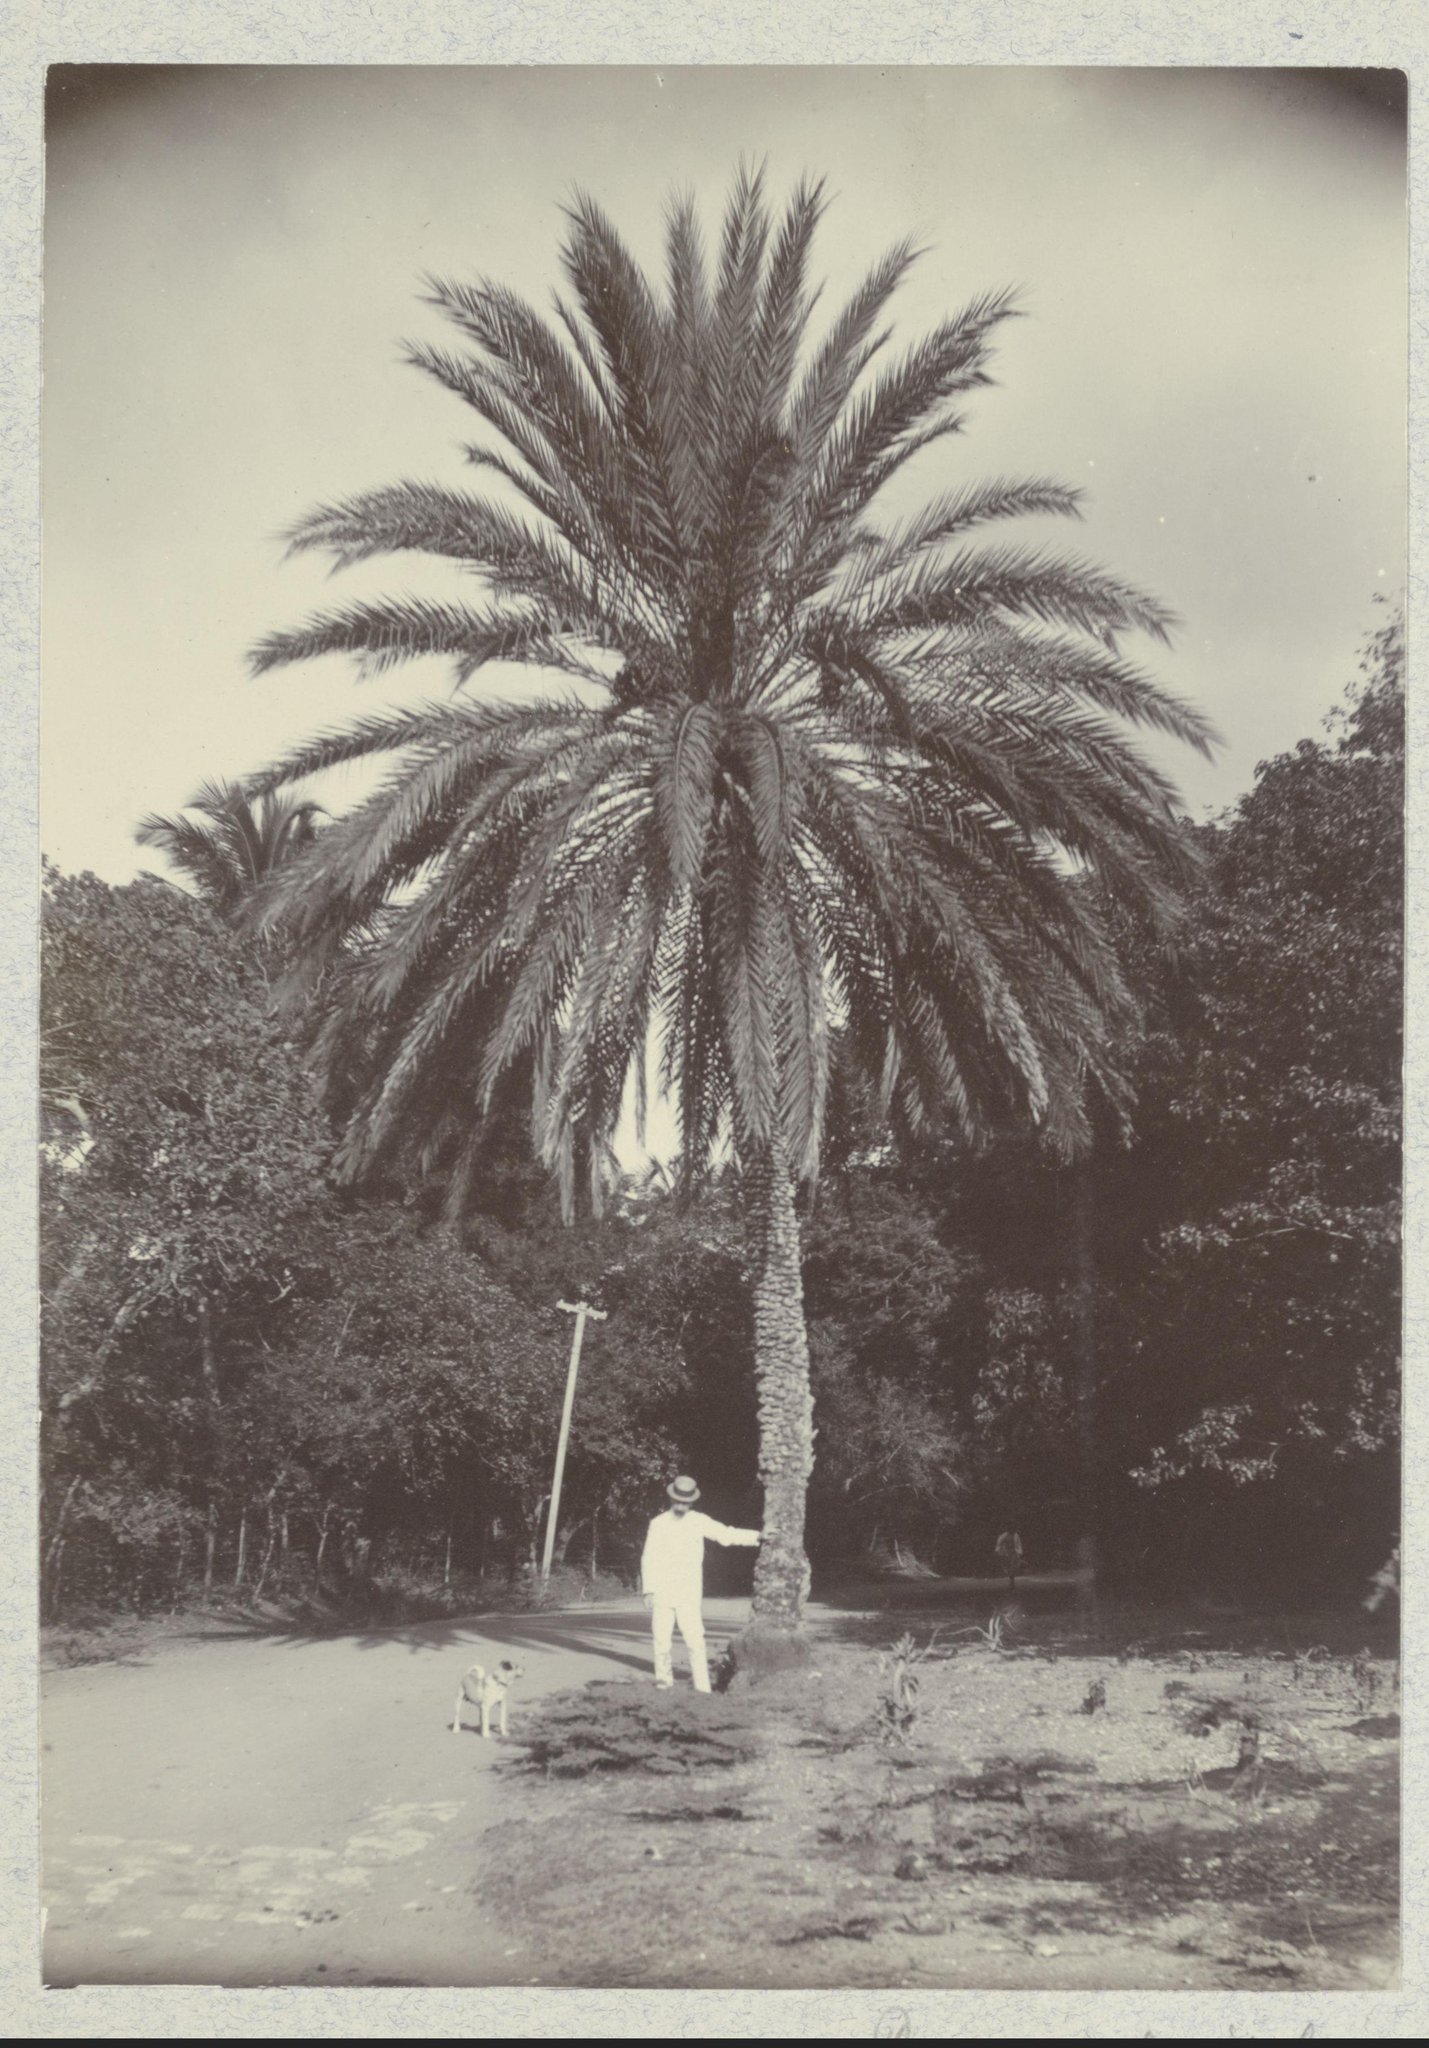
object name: photograph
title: Palmen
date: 1906-1910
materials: photographic support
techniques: photography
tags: trees: palm-tree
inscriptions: inscription: ‘Palmen bij 't Suikertuintje. Juni 1910. Curaçao. de Heer Resler’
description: Een man poseert bij een palmboom, bij landhuis Zuikertuintje in Willemstad op Curaçao, juni 1910. Onderdeel van het fotoalbum van de familie Boom-Gonggrijp in Suriname en Curaçao.